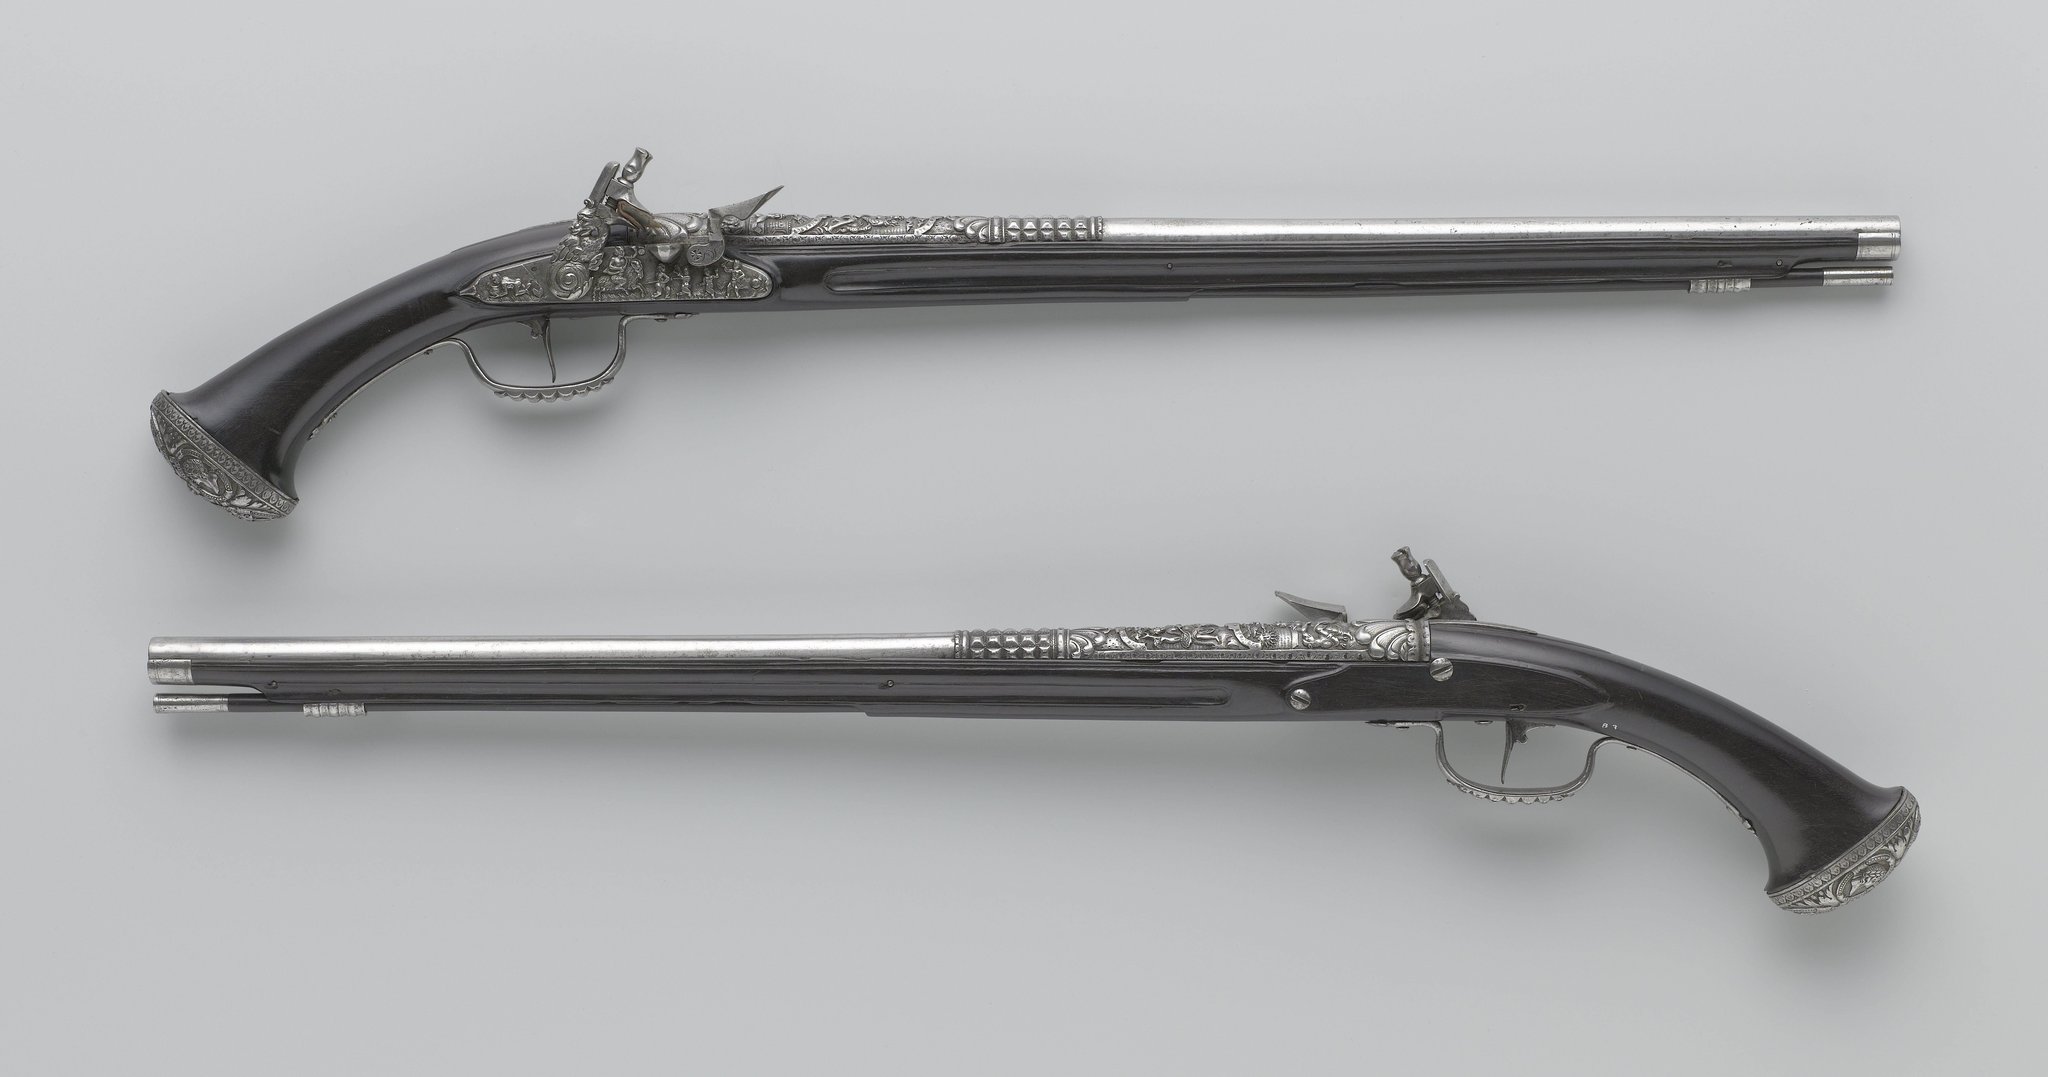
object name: flintlock pistol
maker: Anonymous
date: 1645-1650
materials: wood, iron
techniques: grinding, relief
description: These two flintlock pistols have exceptionally long barrels. Their fine decoration is characteristic of a group of arms produced around 1650 in the region between Maastricht, Liège and Sedan. The lockplates (on the side of the pistols) are decorated with a Classical scene featuring the wine god Bacchus. The cock is in the form of a snake with a coiled tail.